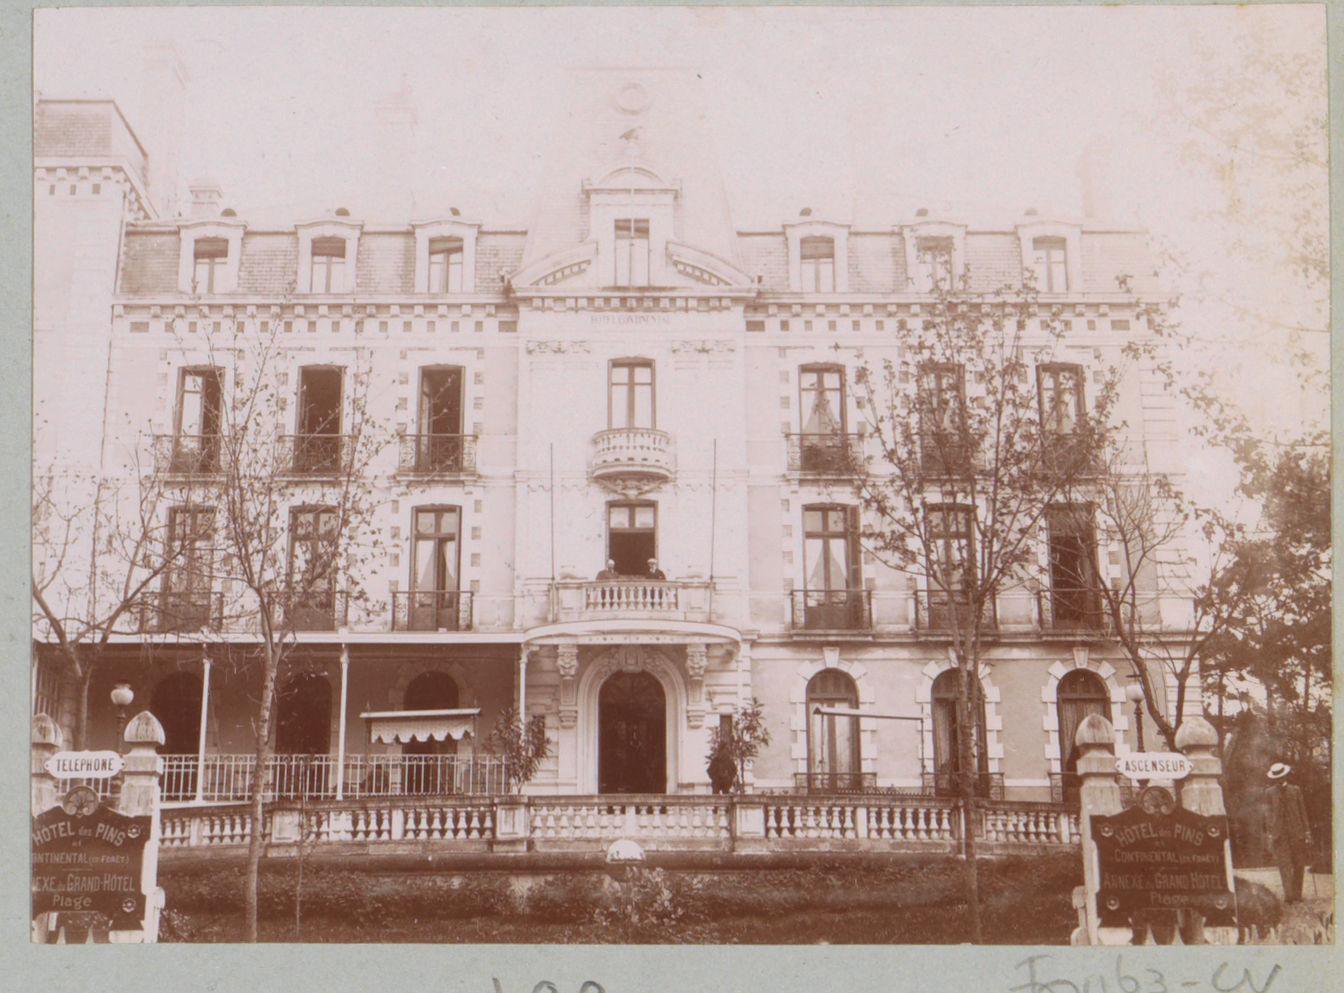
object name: photograph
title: Voorgevel van Grand Hôtel des Pins et Continental in Arcachon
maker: delizy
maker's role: manufacturer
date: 1803-1897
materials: paper, photographic support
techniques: gelatin silver print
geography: arcachon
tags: façade (of house or building), hotel, hostelry, inn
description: Onderdeel van Fotoalbum van een Franse amateurfotograaf met opnames van uitstapjes in Frankrijk, Spanje, België, Luxemburg en Nederland, de eerste automobielen en autoraces.